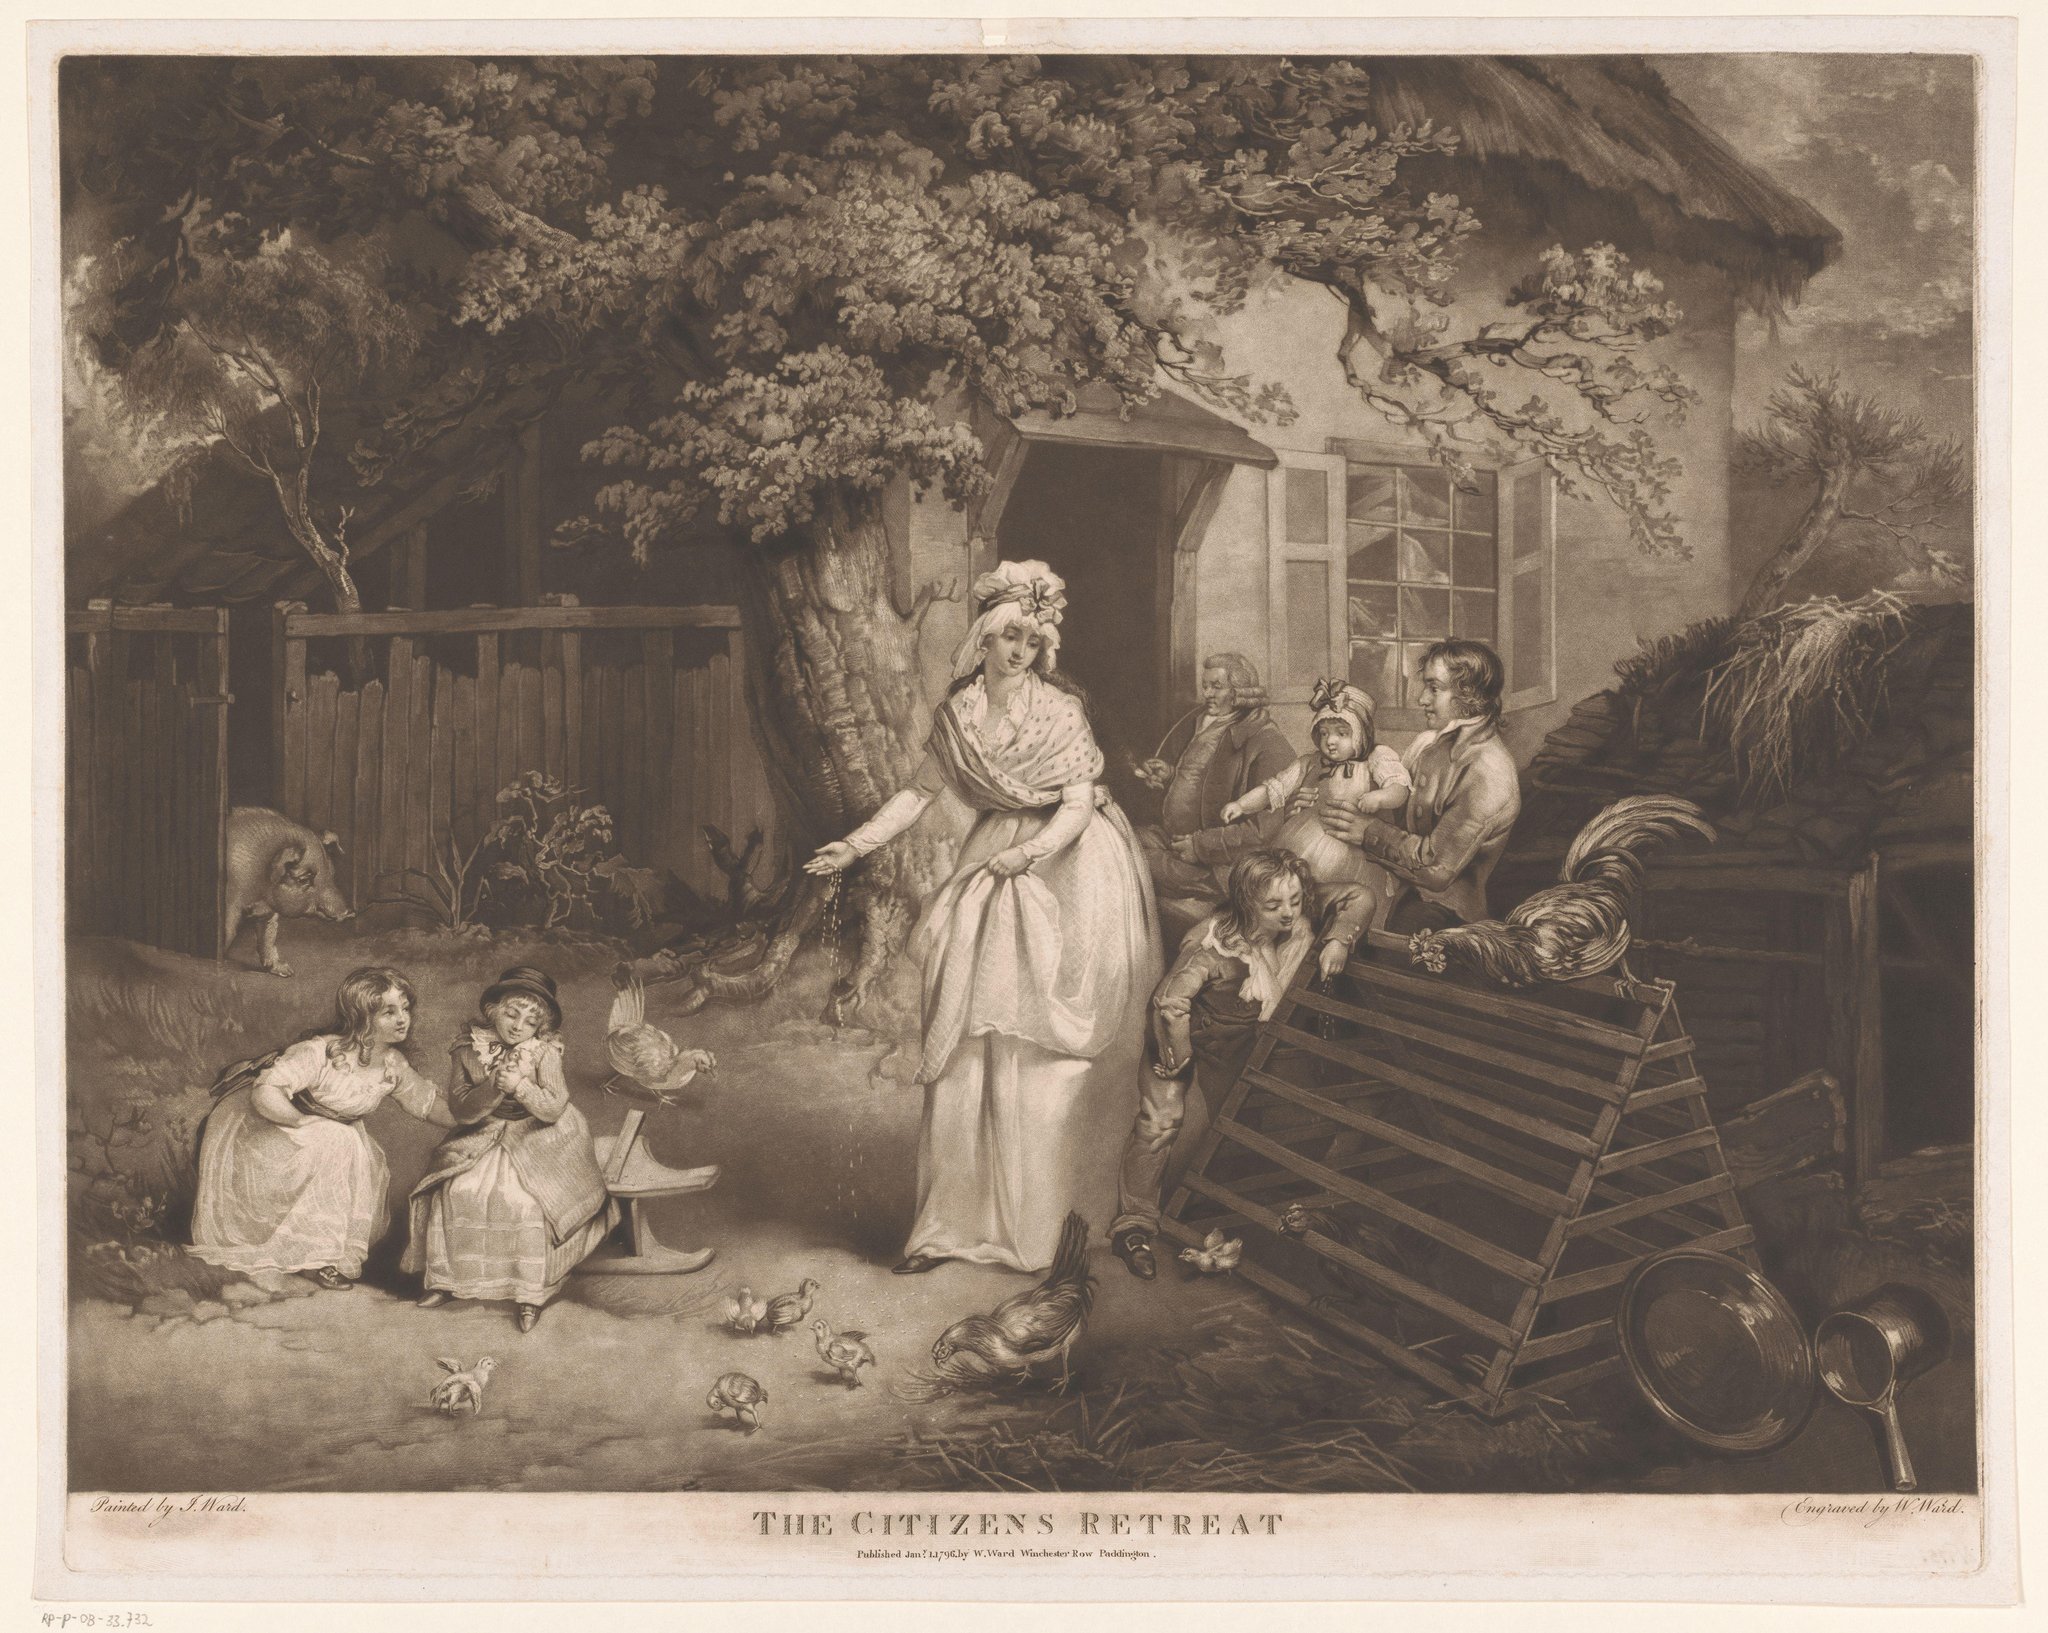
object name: print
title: The Citizens Retreat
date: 1796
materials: paper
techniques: mezzotint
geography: paddington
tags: the family travelling, on holiday, fowl (cock, hen, chicken, etc.) (+ feeding and care of young), country-house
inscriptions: number: ‘N. 175’, collector's mark: Lugt 2228